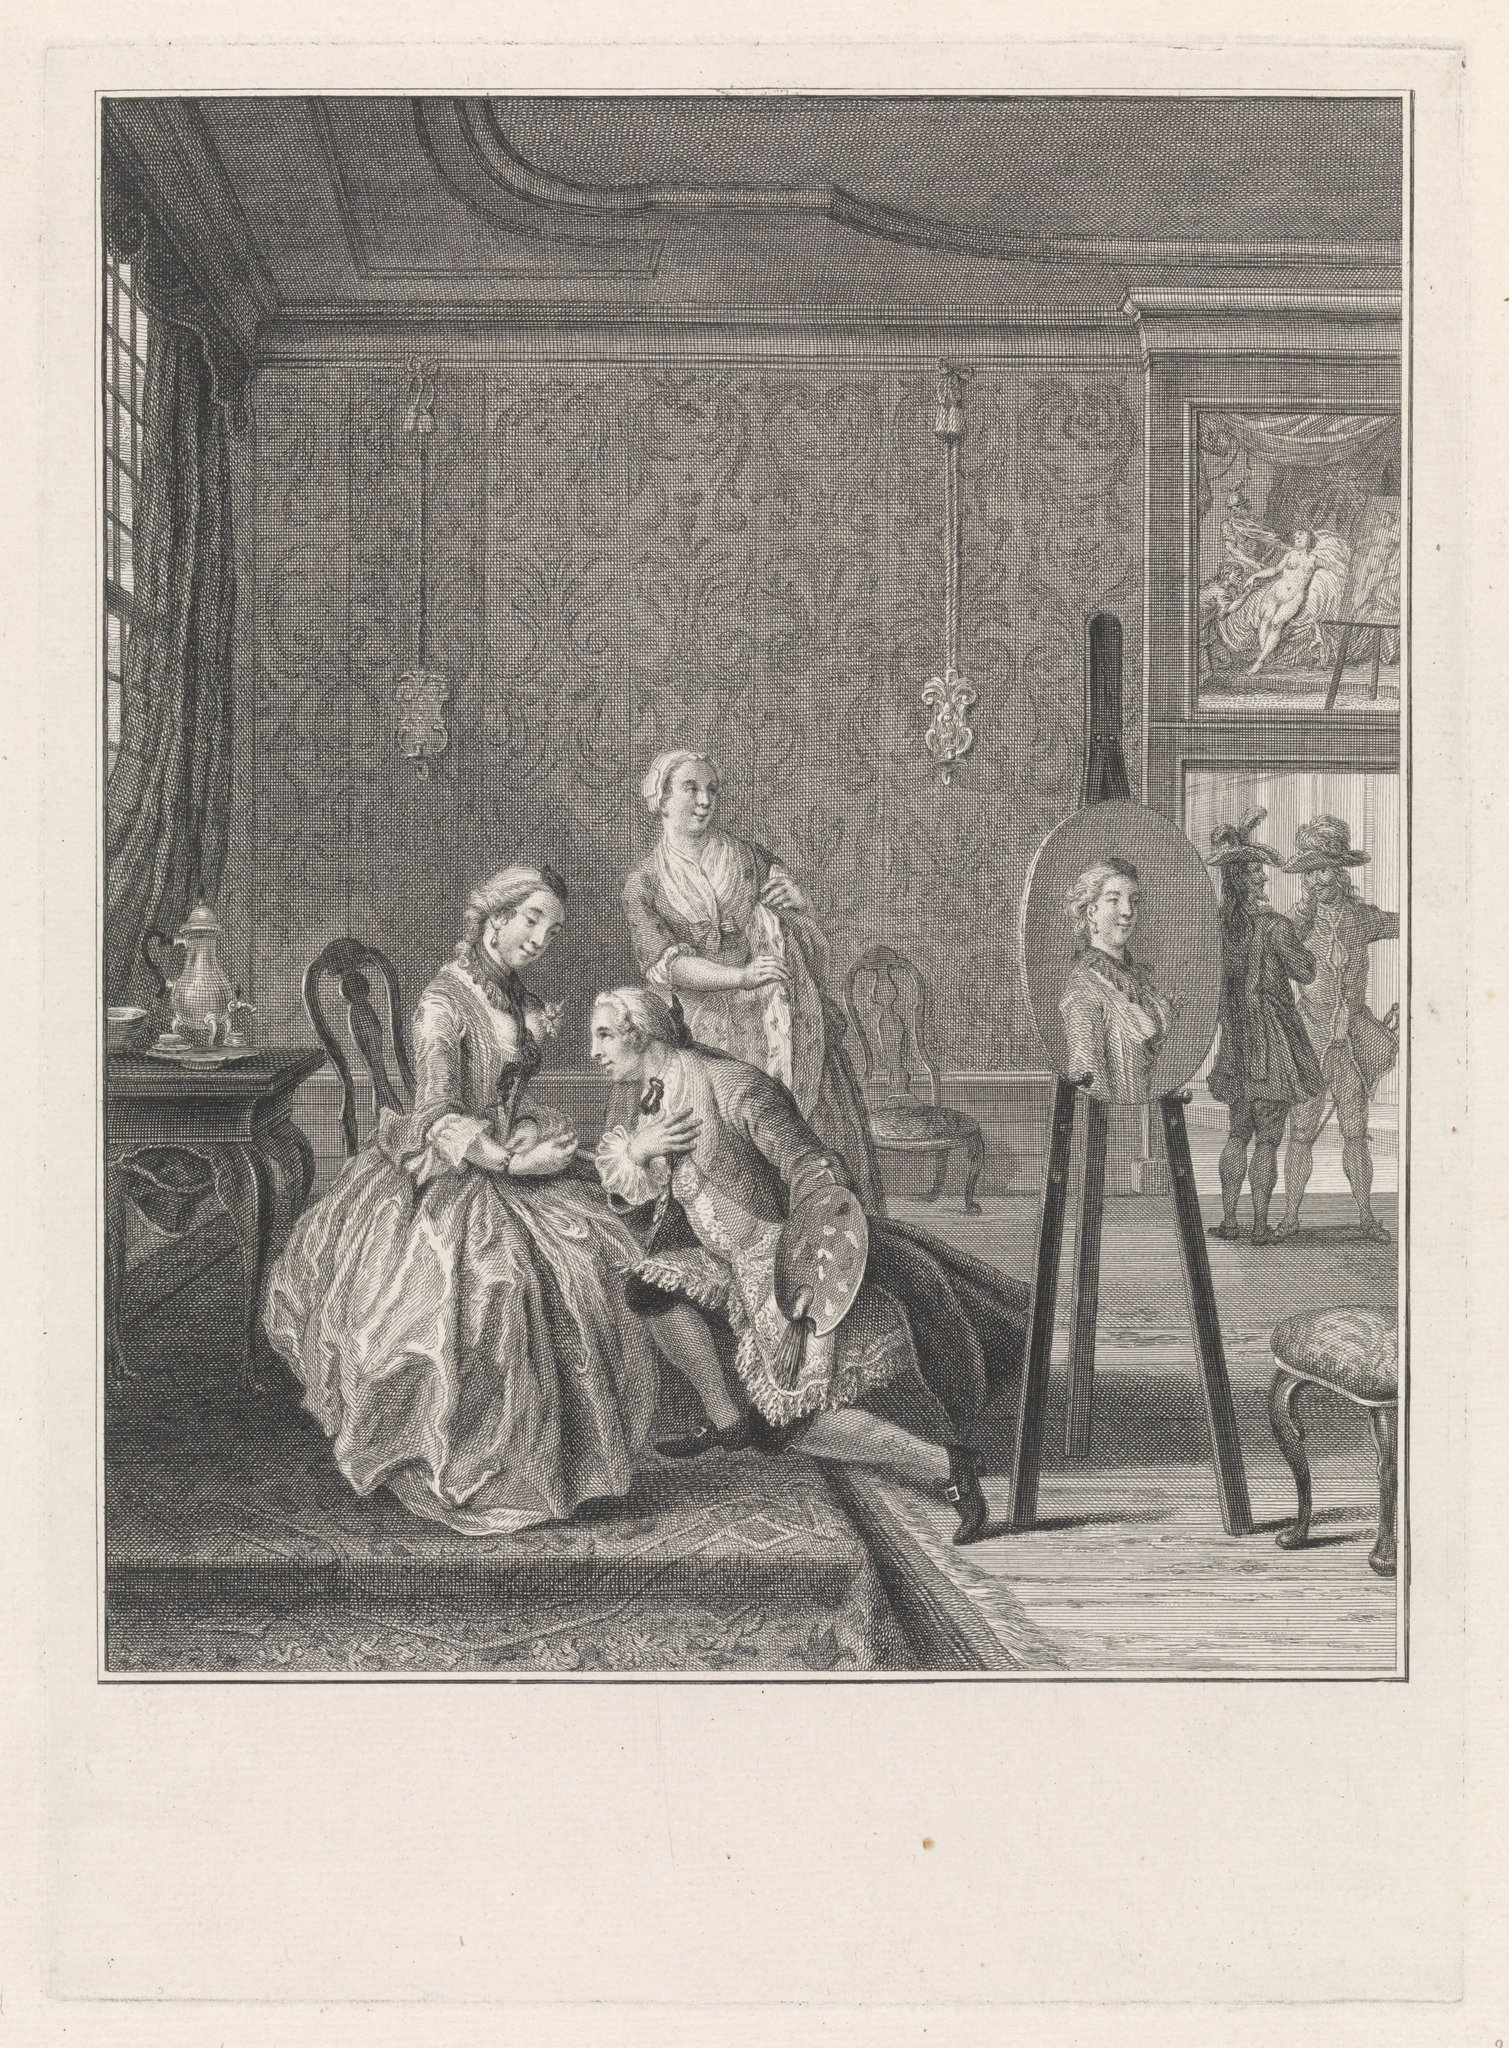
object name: print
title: De schilder door liefde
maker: pieter tanjé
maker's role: draughtsman, print maker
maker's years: 1706-1761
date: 1761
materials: paper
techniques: engraving, etching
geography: amsterdam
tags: kneeling figure, apelles paints campaspe and falls in love with her; alexander yields her to him, painter working from clothed model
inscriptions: collector's mark: Lugt 240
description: De schilder Eduard verklaart Leonoor, wiens portret hij vervaardigd heeft, zijn liefde. Bij de deur staat Leonoor's jaloerse man Don Pedro, die door de schildersknecht bezig wordt gehouden. Boven de deur hangt een schilderij met een voorstelling van Alexander, die de schilder Apelles zijn minnares Campaspe ten geschenke geeft. Scène uit het tweede bedrijf van het toneelstuk De schilder door liefde, van Molière.